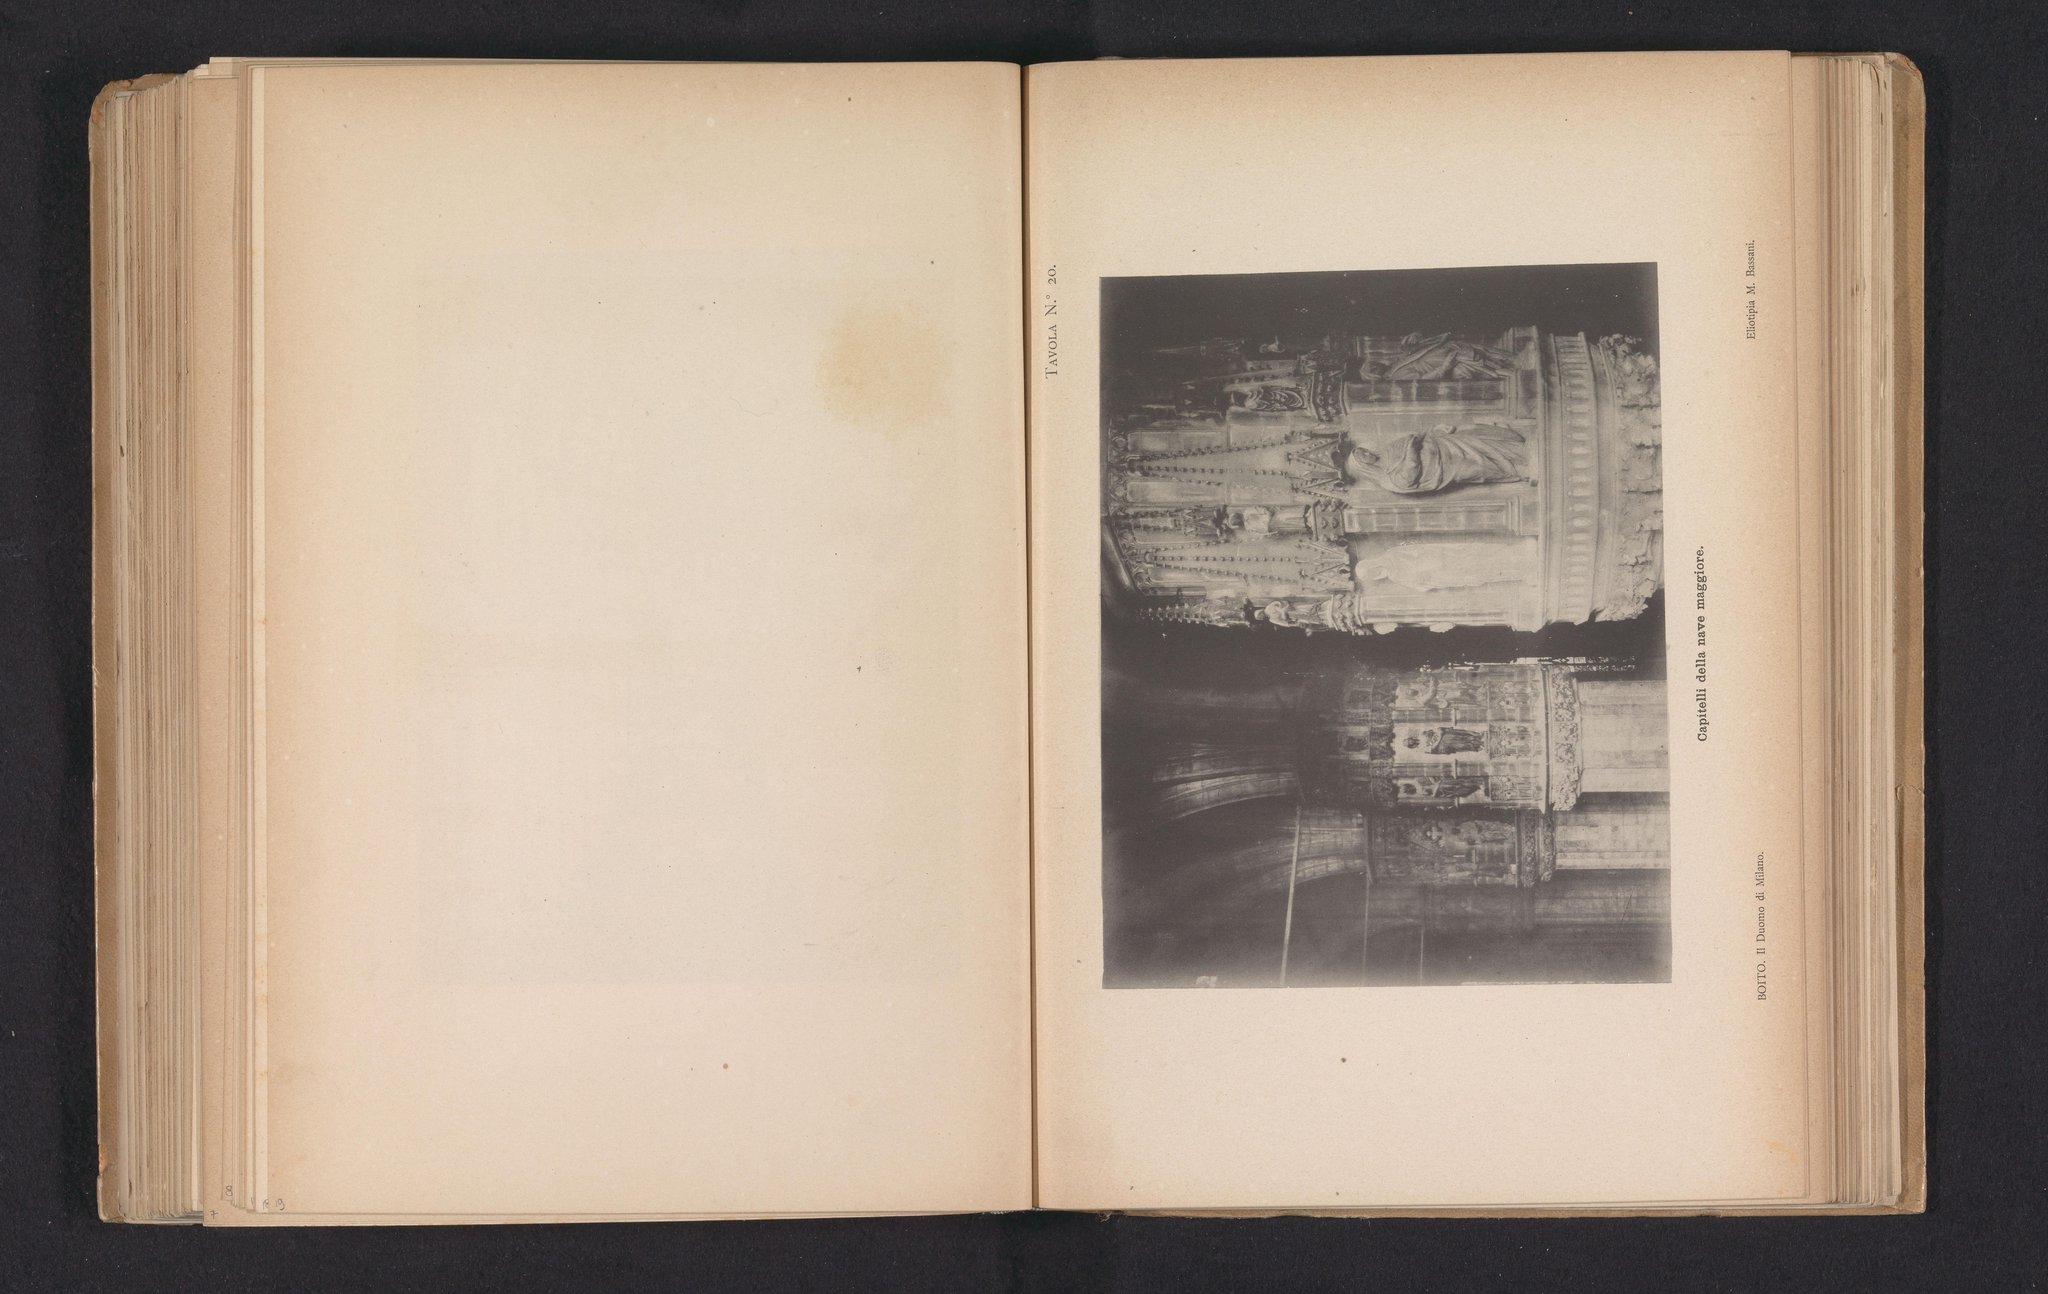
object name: photomechanical print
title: Kapitelen van pilaren in het schip van de Dom van Milaan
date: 1879-1889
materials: paper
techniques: photograph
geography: milan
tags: parts of church interior: nave, capital (~ column, pillar)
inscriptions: number: ‘Tavola No. 20.’